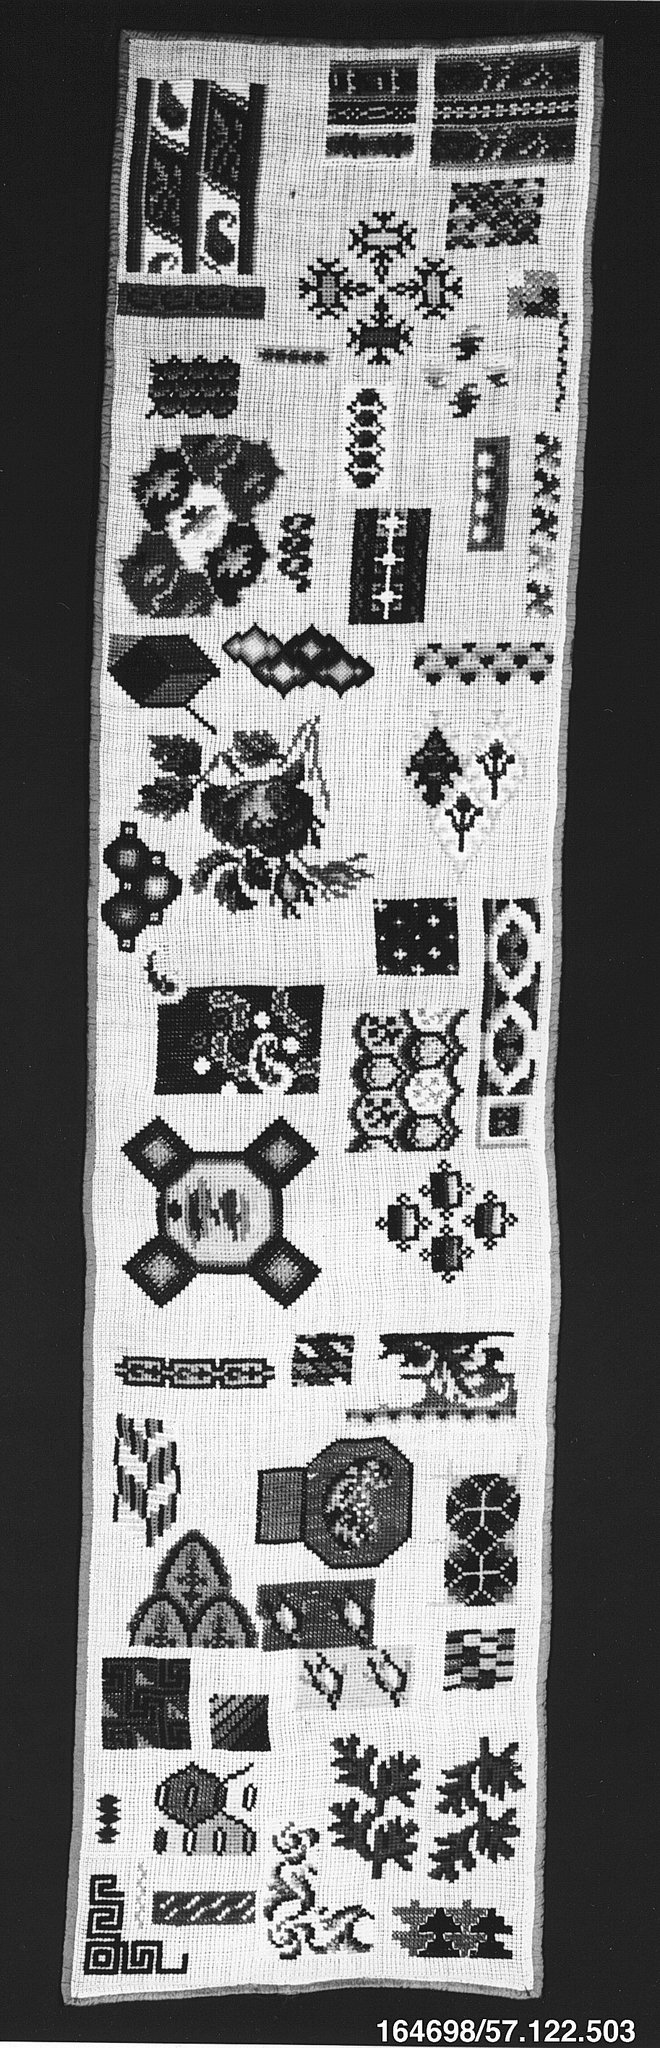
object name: sampler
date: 1801-1900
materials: canvas, cotton, silk, wool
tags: flowers